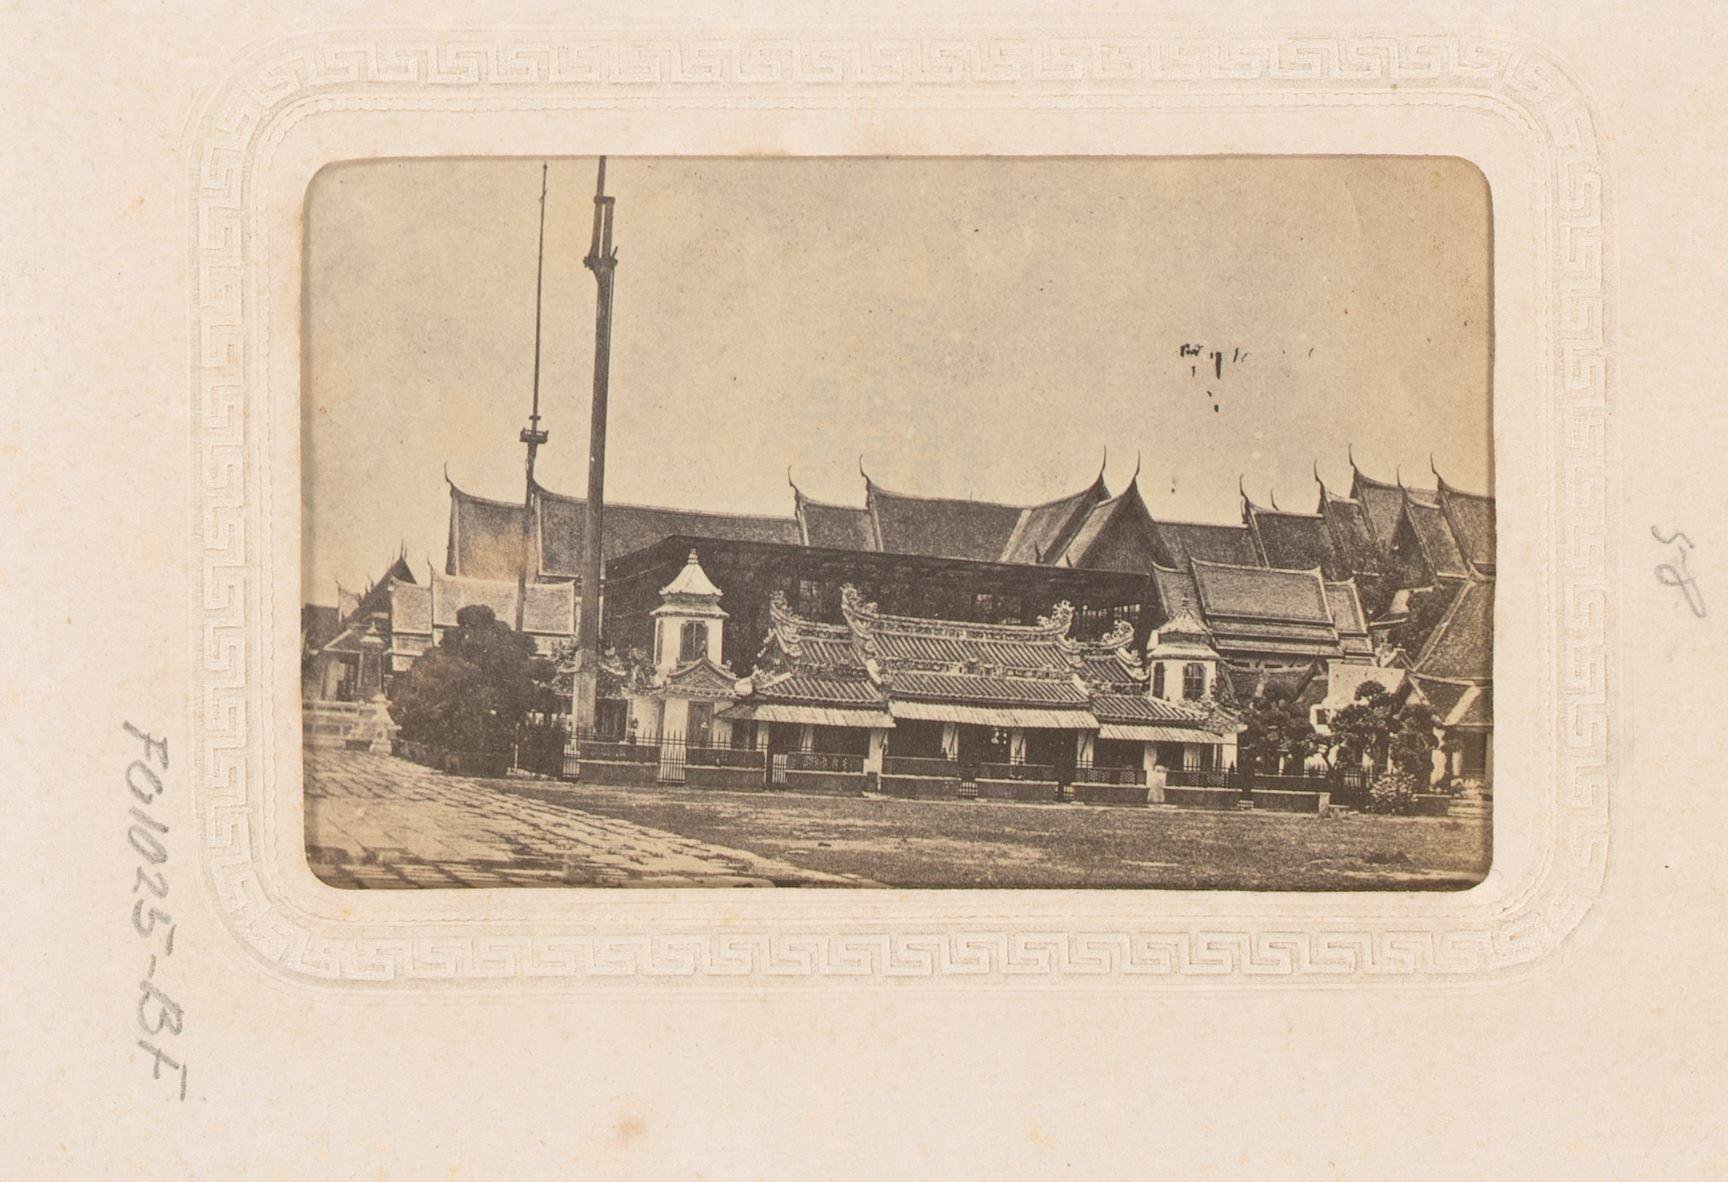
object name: photograph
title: Gezicht op een Chinese kerk te Singapore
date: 1867-1880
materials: cardboard, photographic support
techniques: albumen print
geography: singapore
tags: church (exterior), singapore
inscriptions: annotation: ‘Chin: kerk Singapore’, number: ‘58’